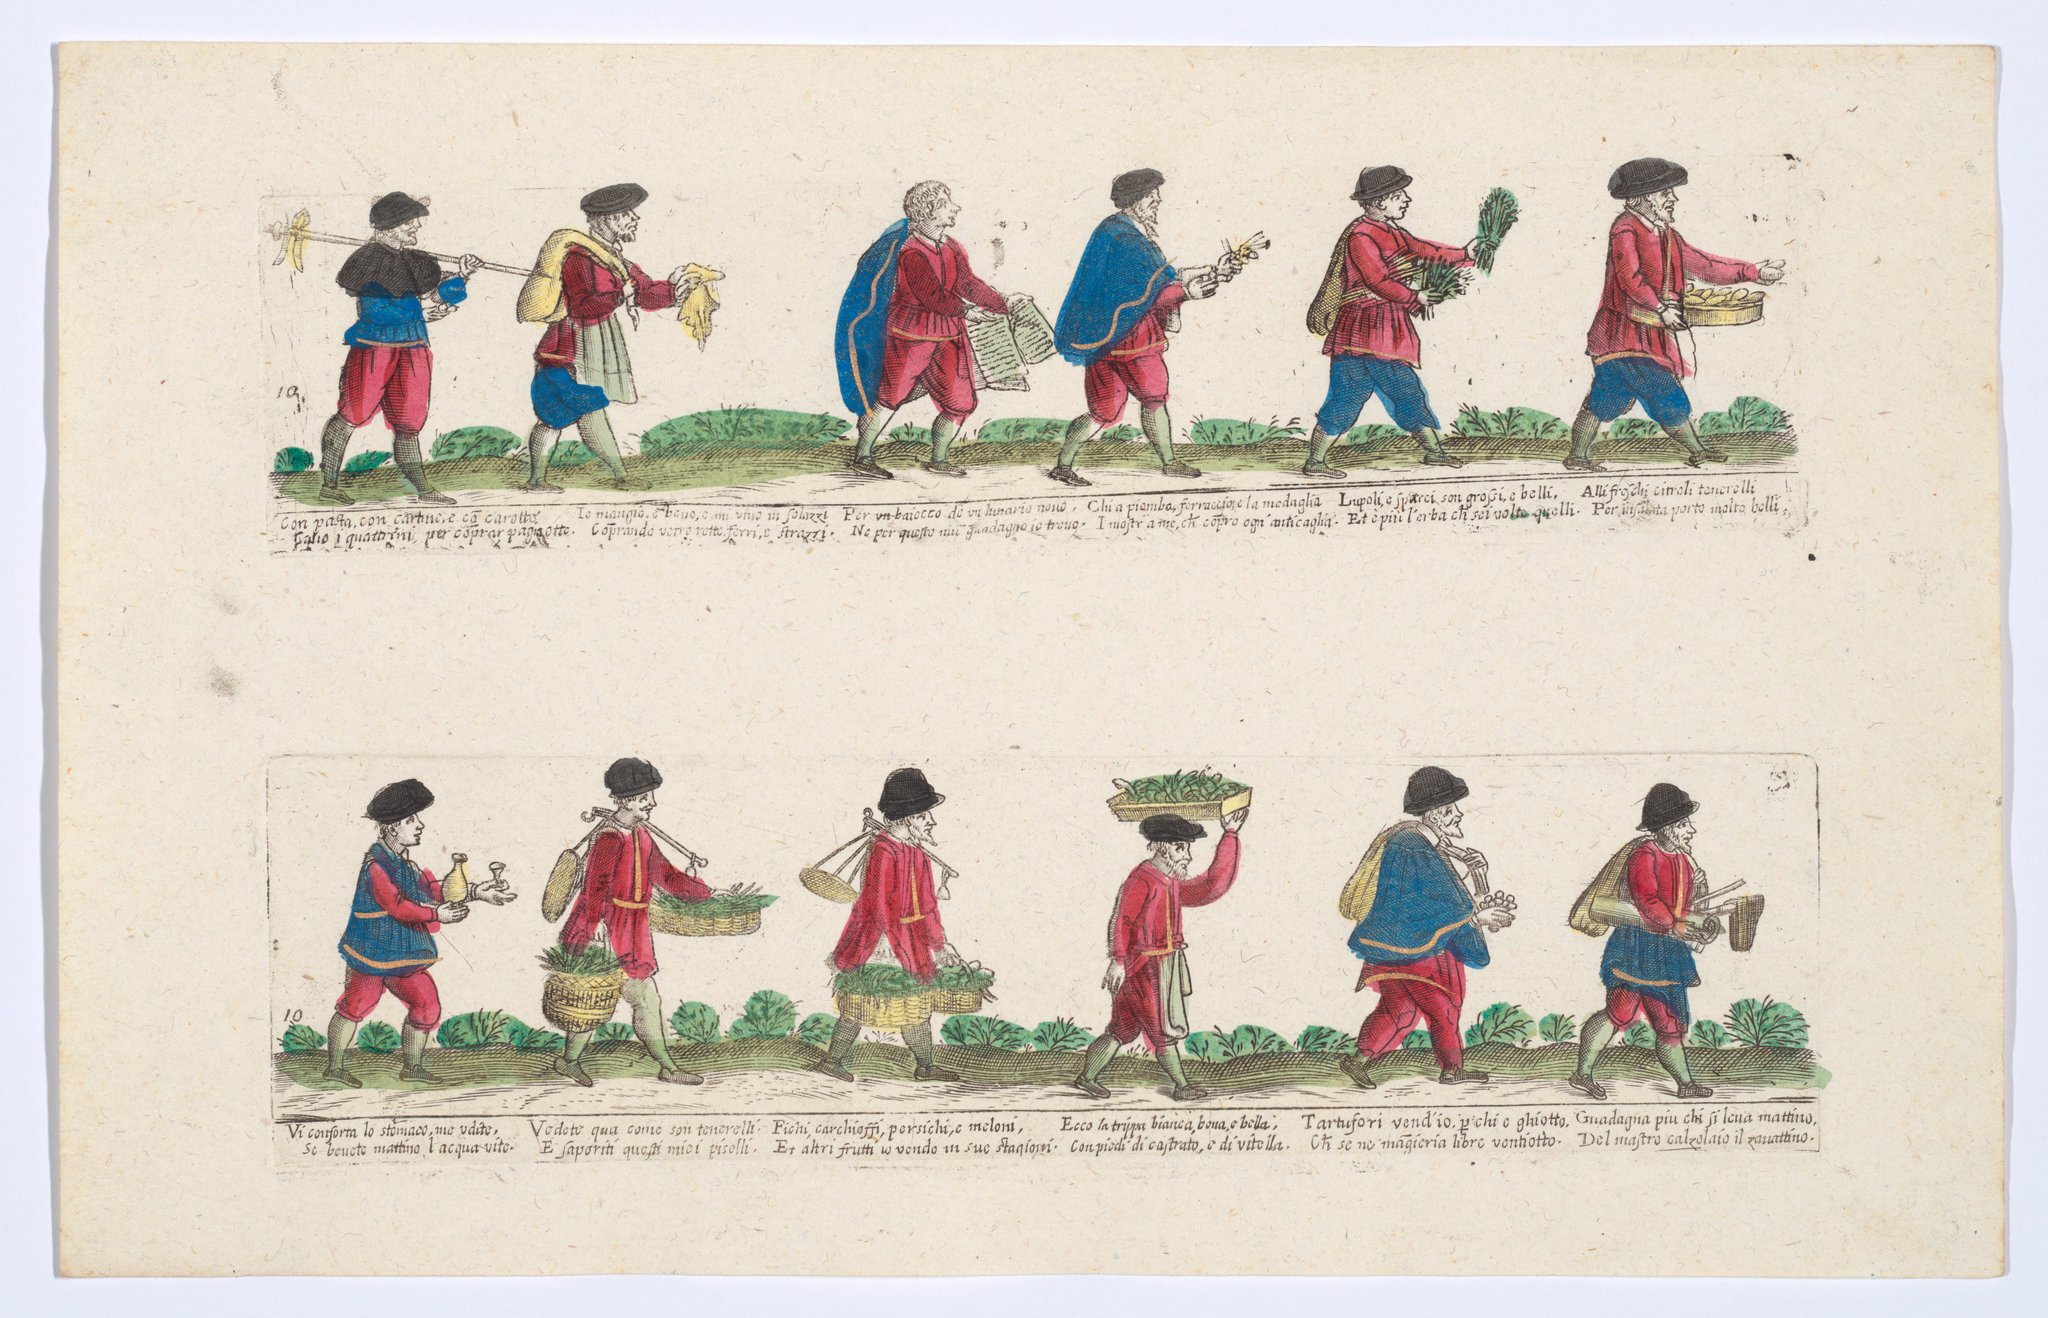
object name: print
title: Plate 10 depicting the trades of Rome, here including vendors of medicine of an upset stomach, artichokes, tripe etc, from the 'Descrición de las artes que se llaman para los calles de la ciudad de Roma'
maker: remondini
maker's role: publisher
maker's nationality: italian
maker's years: 1650-1860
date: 1770-1800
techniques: engraving, hand coloring